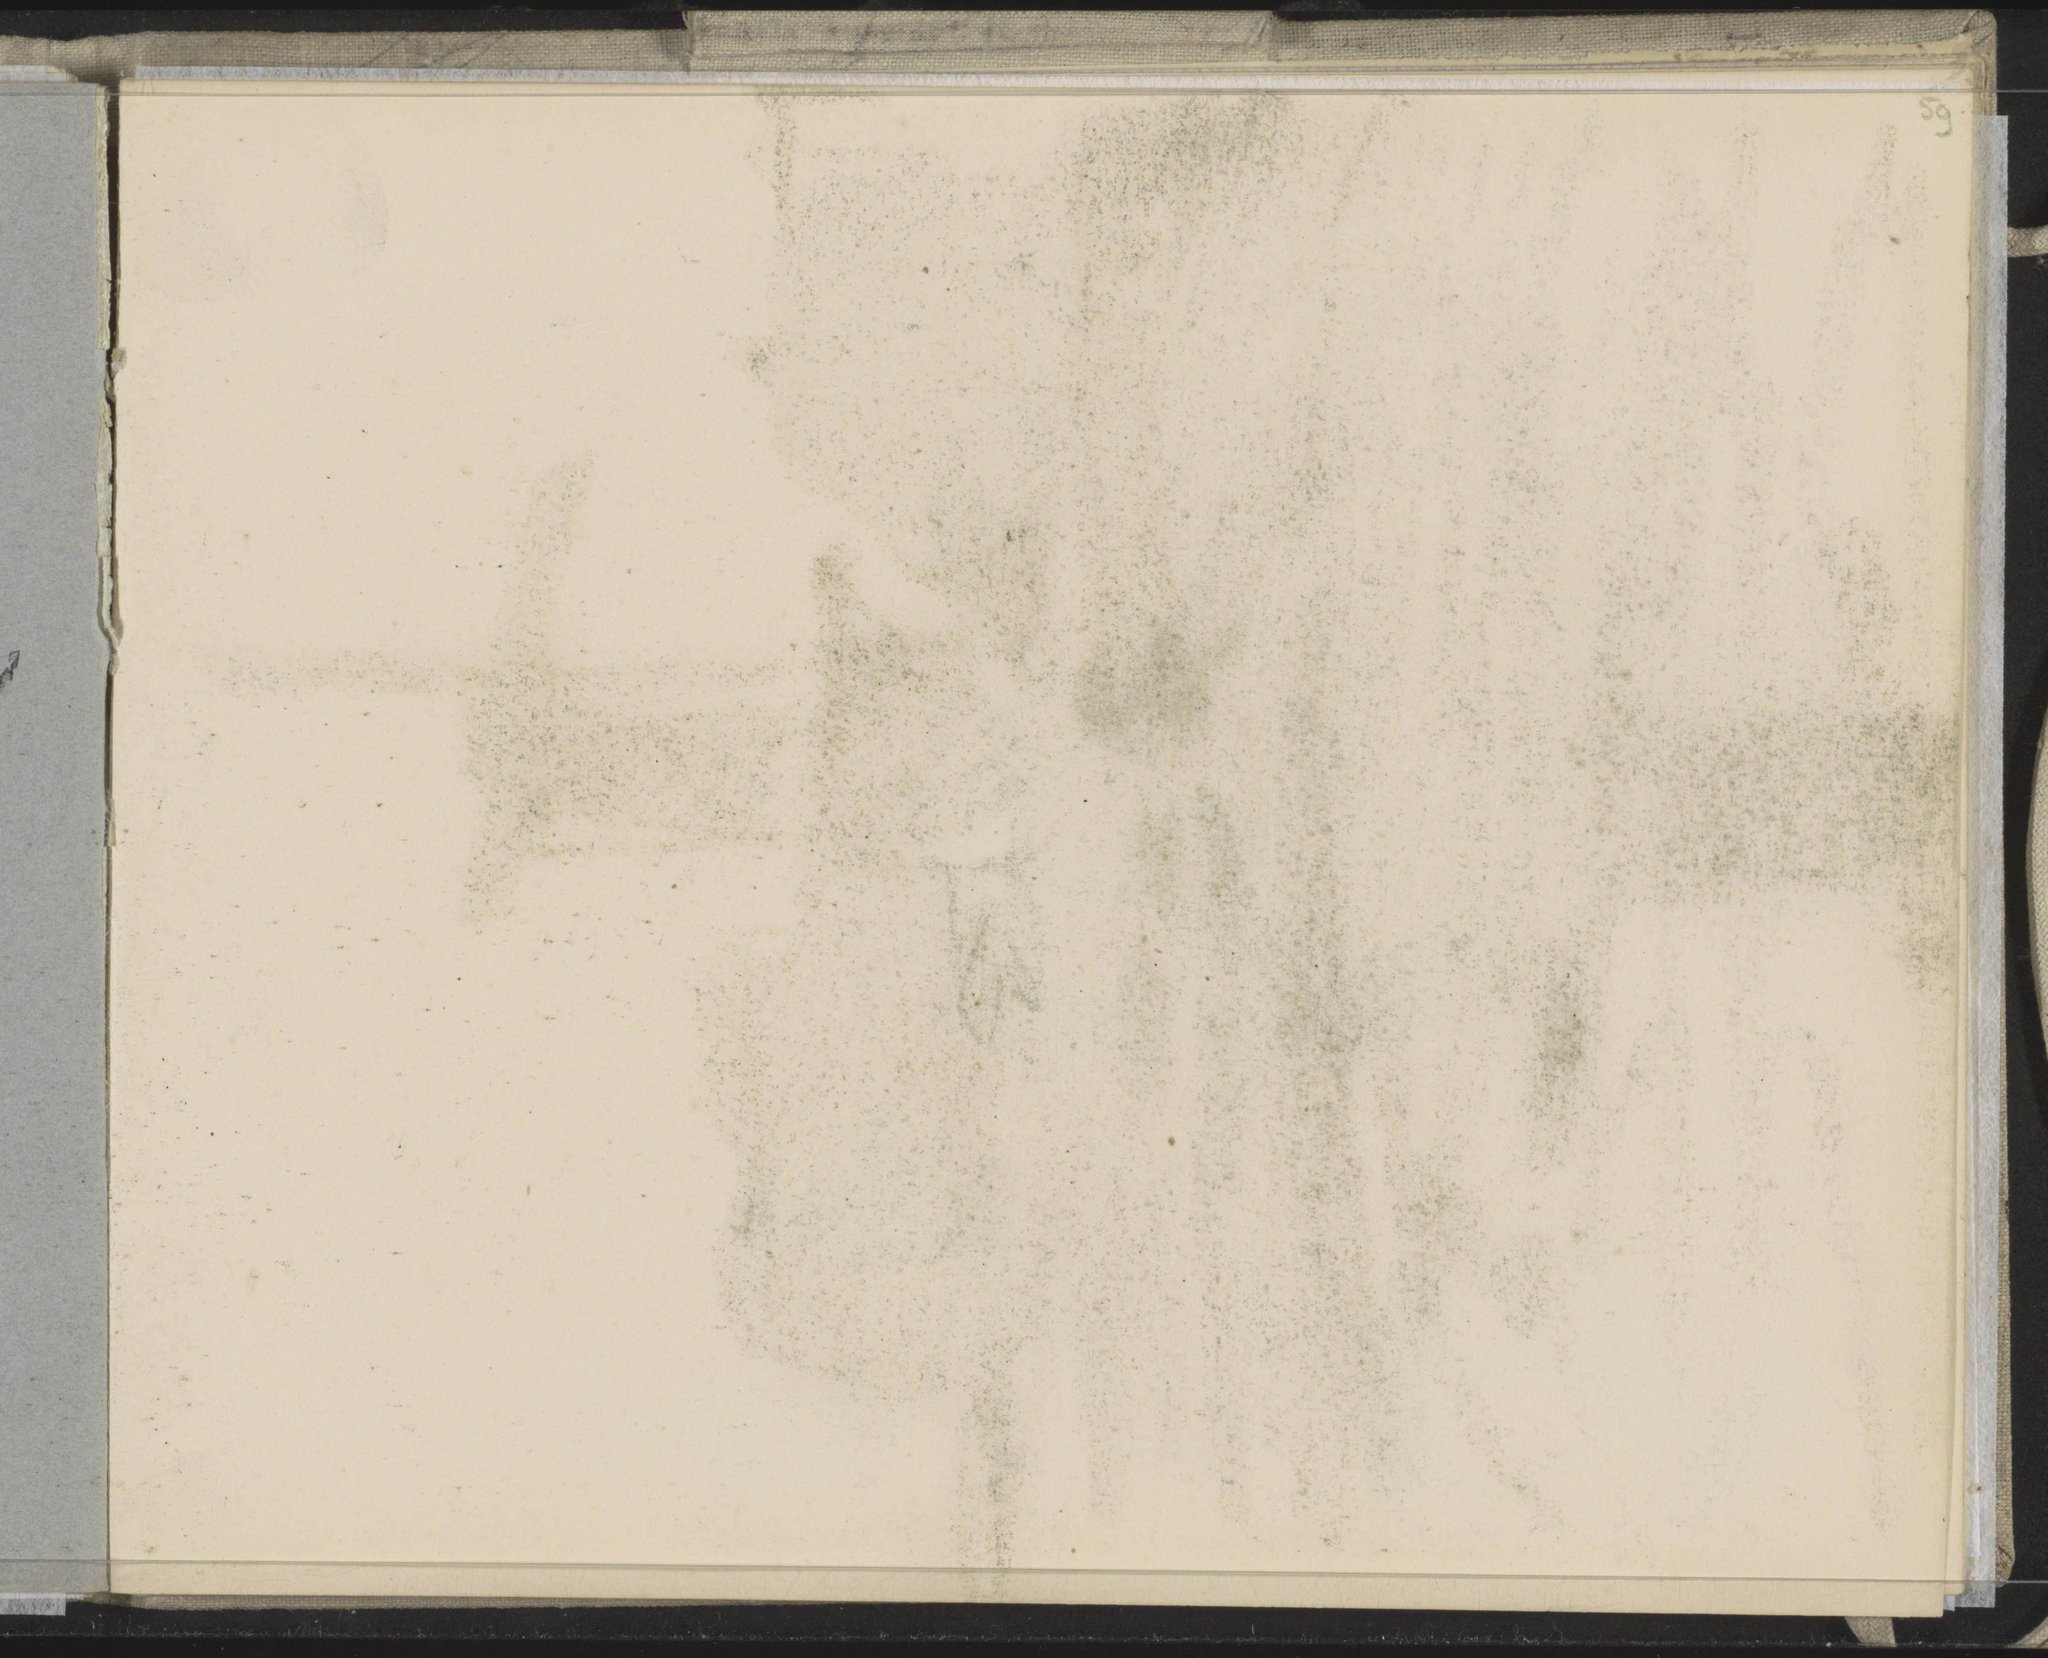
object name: sketchbook leaf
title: Abklatsch van de krijttekening op pagina 58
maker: willem witsen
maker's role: draughtsman, painter, print maker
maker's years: 1860-1923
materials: paper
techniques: printmaking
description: Pagina 59 uit een schetsboek met 43 bladen.